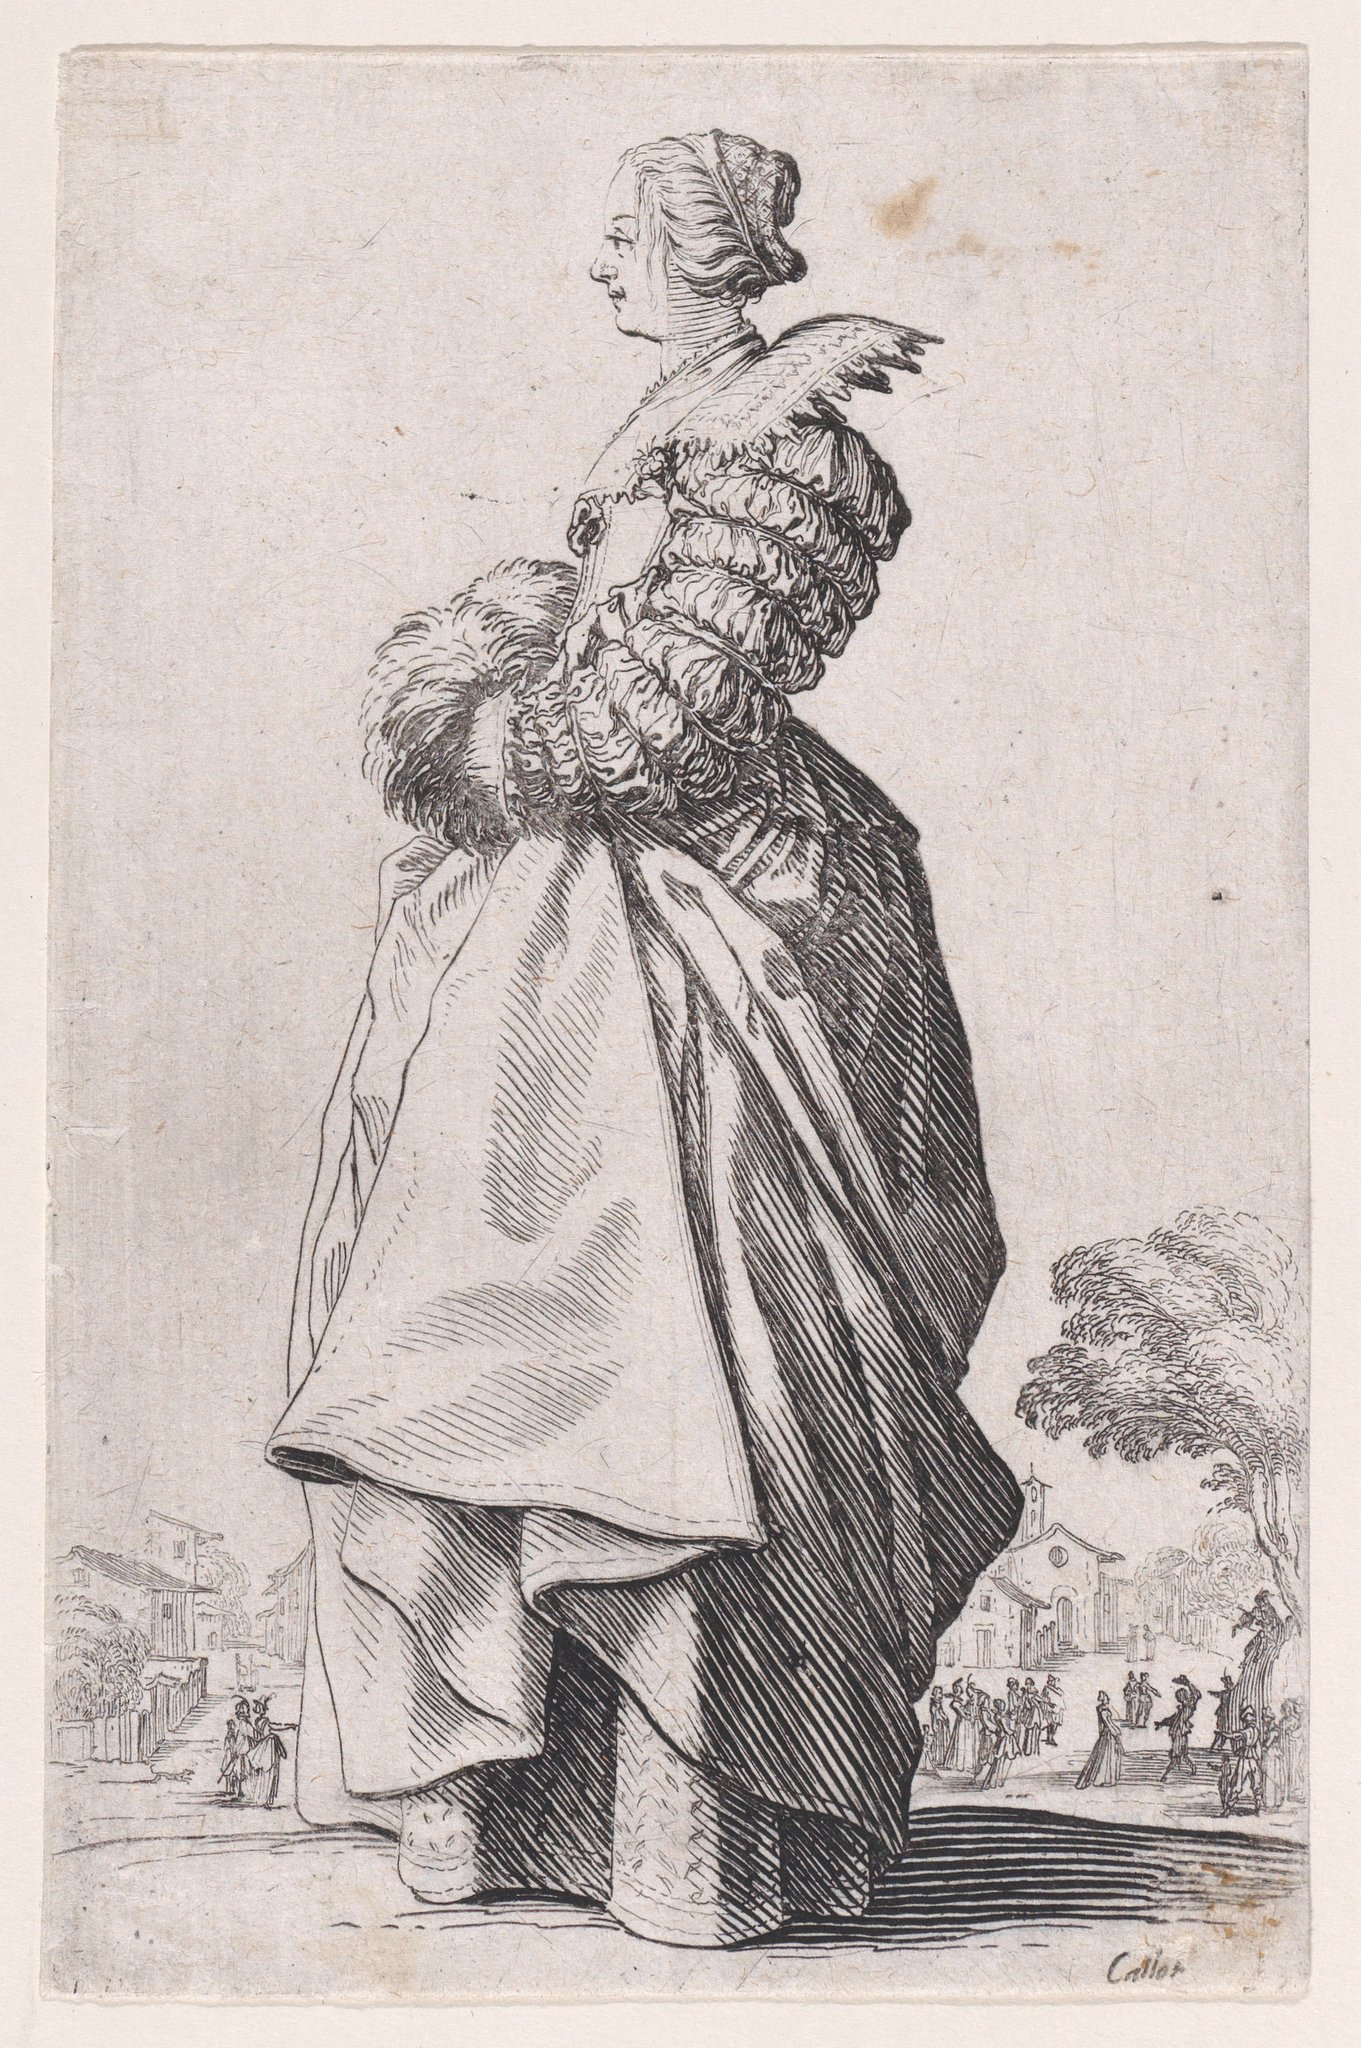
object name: print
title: La Dame de Profil Ayant les Mains dans son Manchon (The Lady in Profile Having her Hands inside of her Muff), from "La Noblesse" (The Nobility)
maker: jacques callot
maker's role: artist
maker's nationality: french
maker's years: 1592-1635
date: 1623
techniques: etching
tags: women